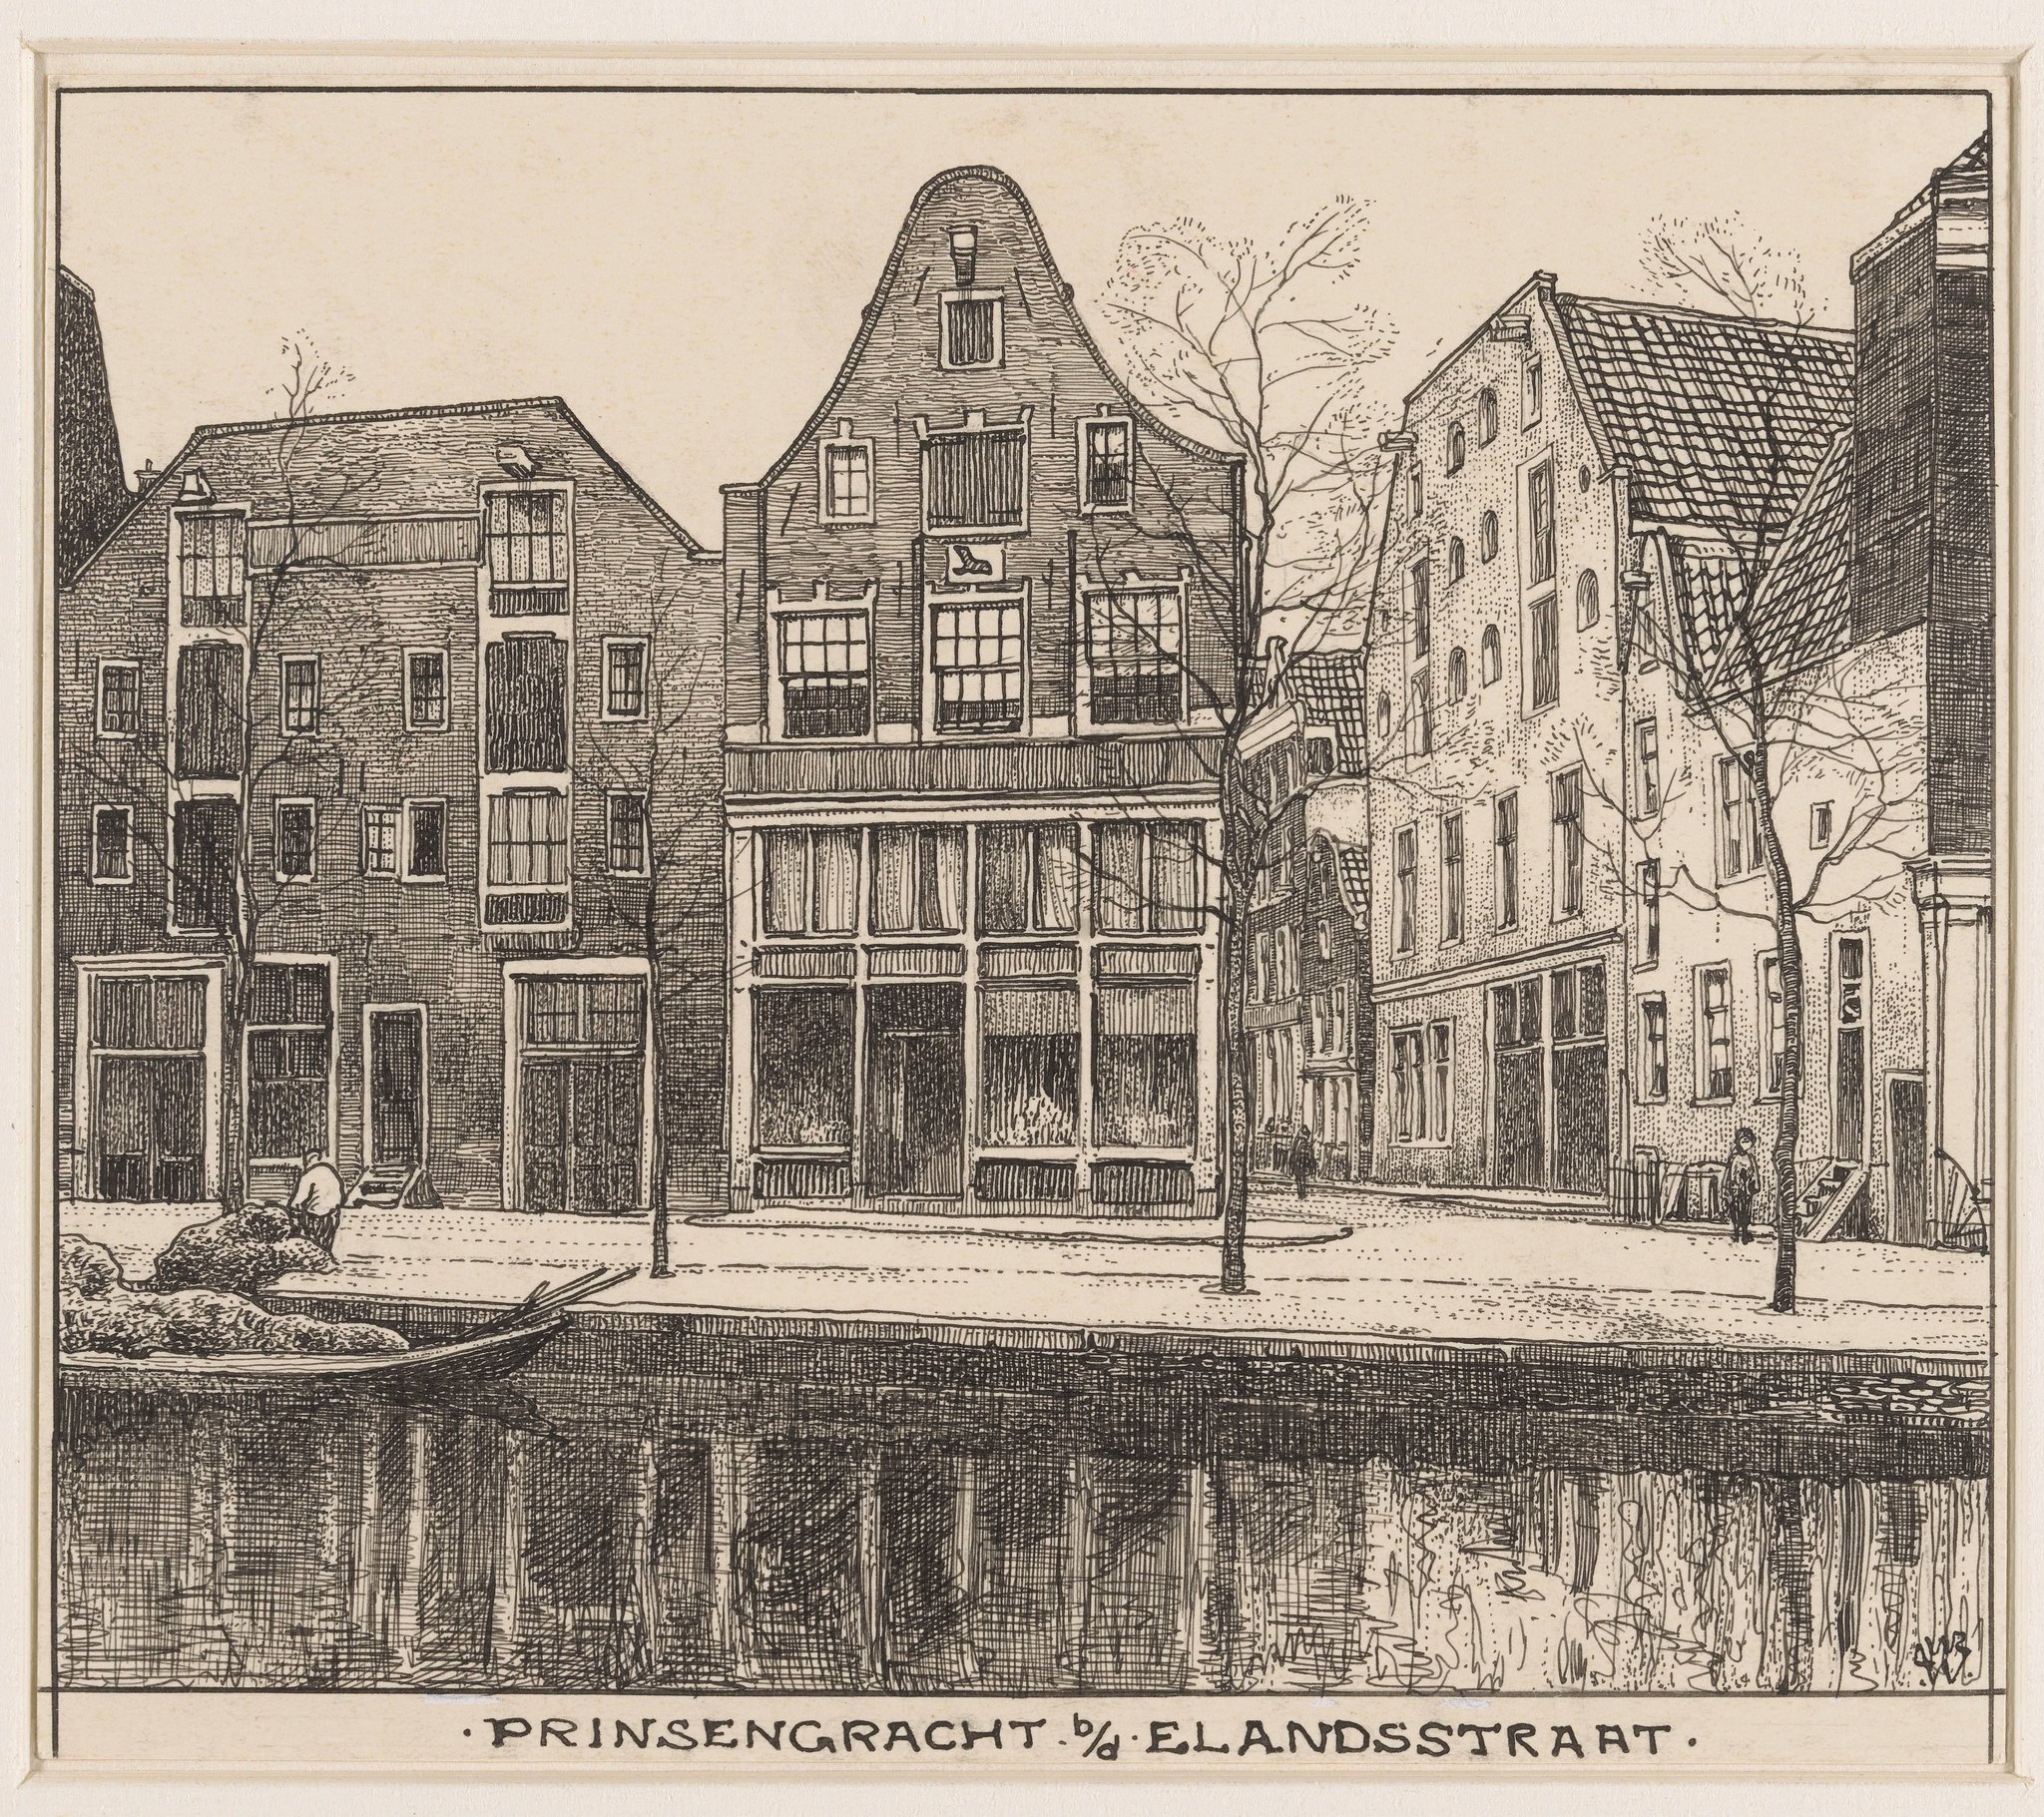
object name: drawing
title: De Prinsengracht te Amsterdam, bij de Elandsstraat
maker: willem wenckebach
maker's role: designer, draughtsman, painter, print maker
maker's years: 1860-1937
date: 1870-1926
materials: ink, paper, pencil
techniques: pen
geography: amsterdam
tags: canals, waters (in city)